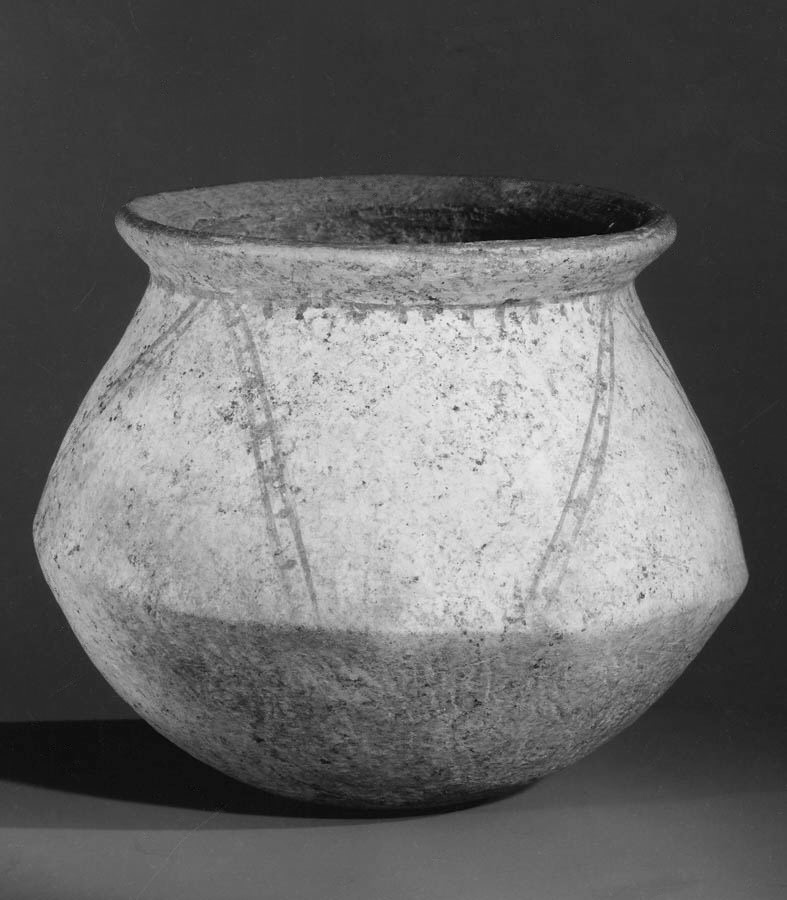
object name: jar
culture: thai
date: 3500 BCE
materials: pottery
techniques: painting